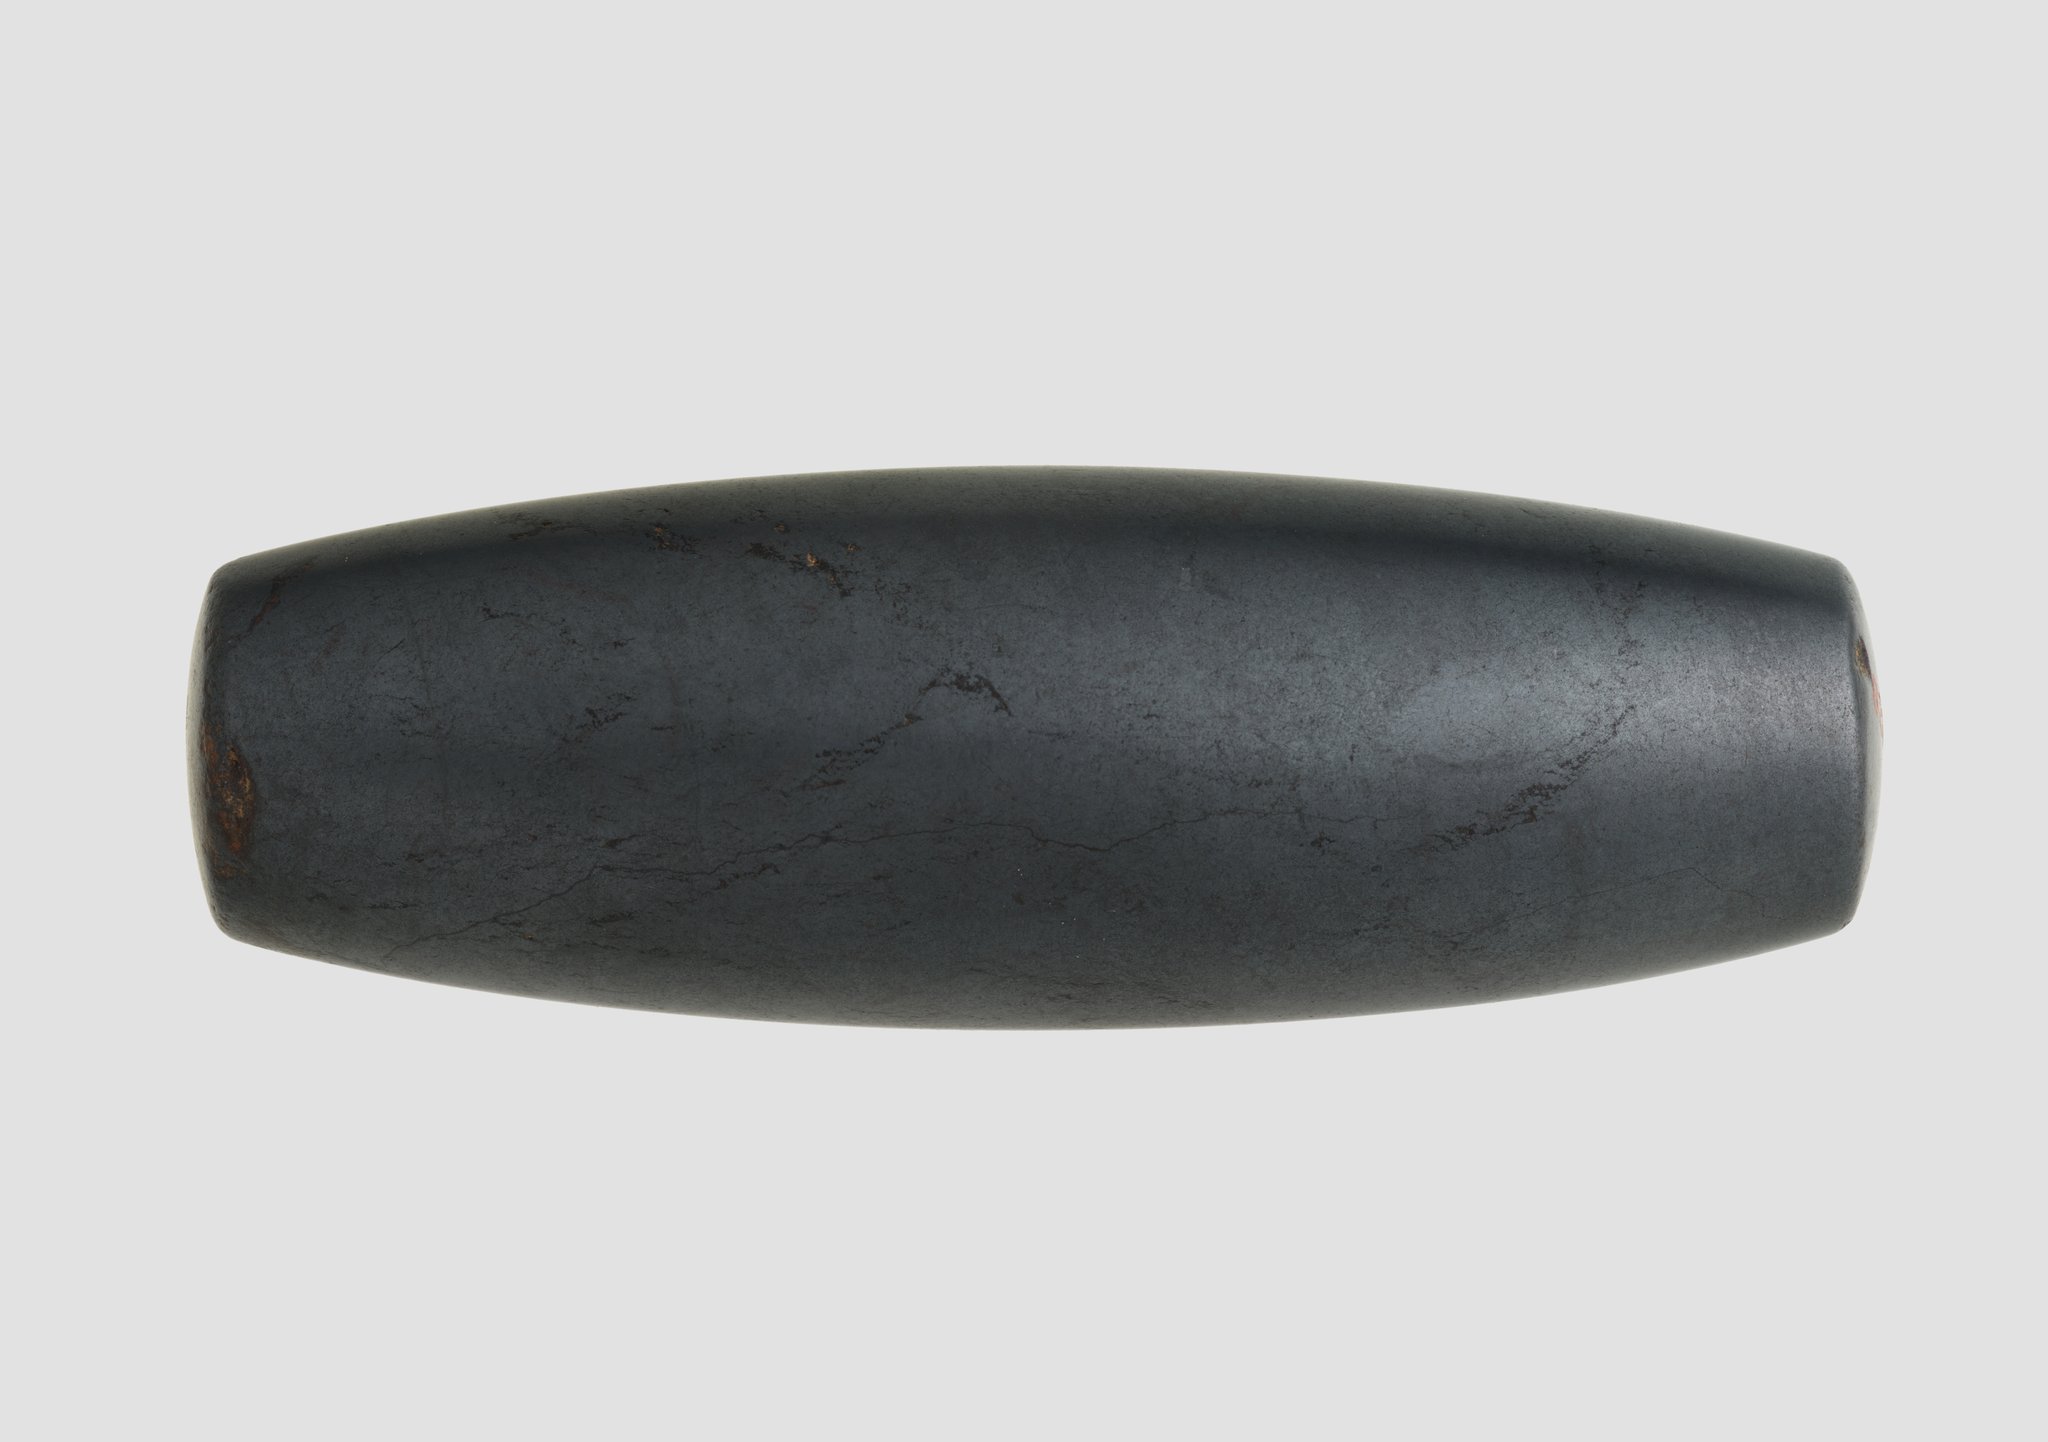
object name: weight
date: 3000-1 BCE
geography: cyprus or western asia